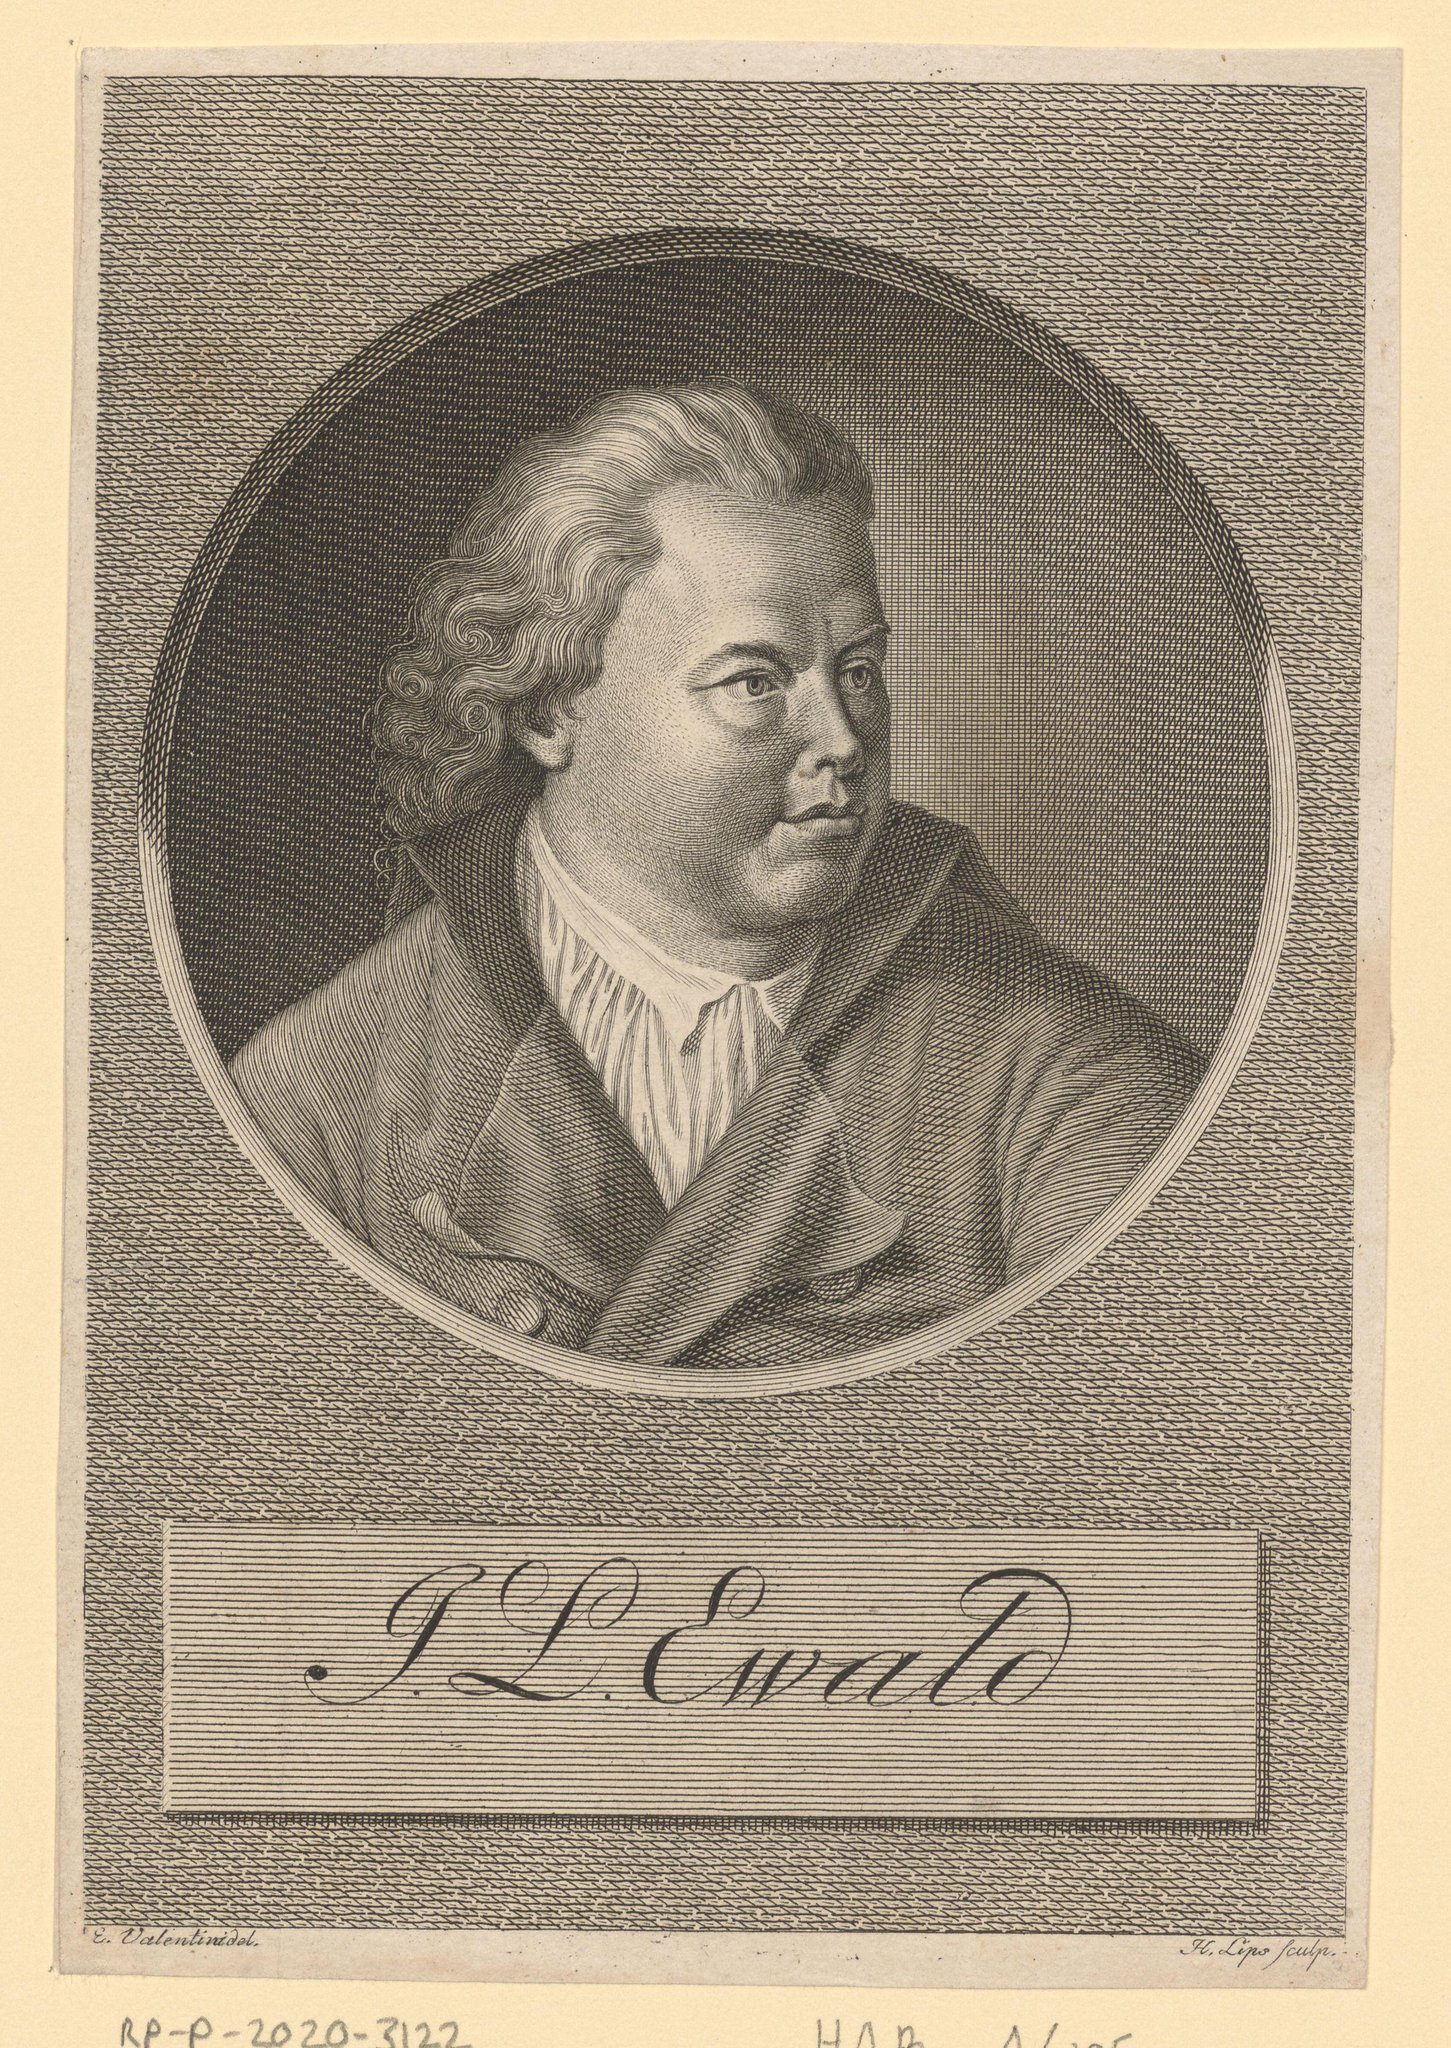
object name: print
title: Portret van Johann Ludwig Ewald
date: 1768-1826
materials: paper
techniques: engraving, etching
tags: theologian, historical persons